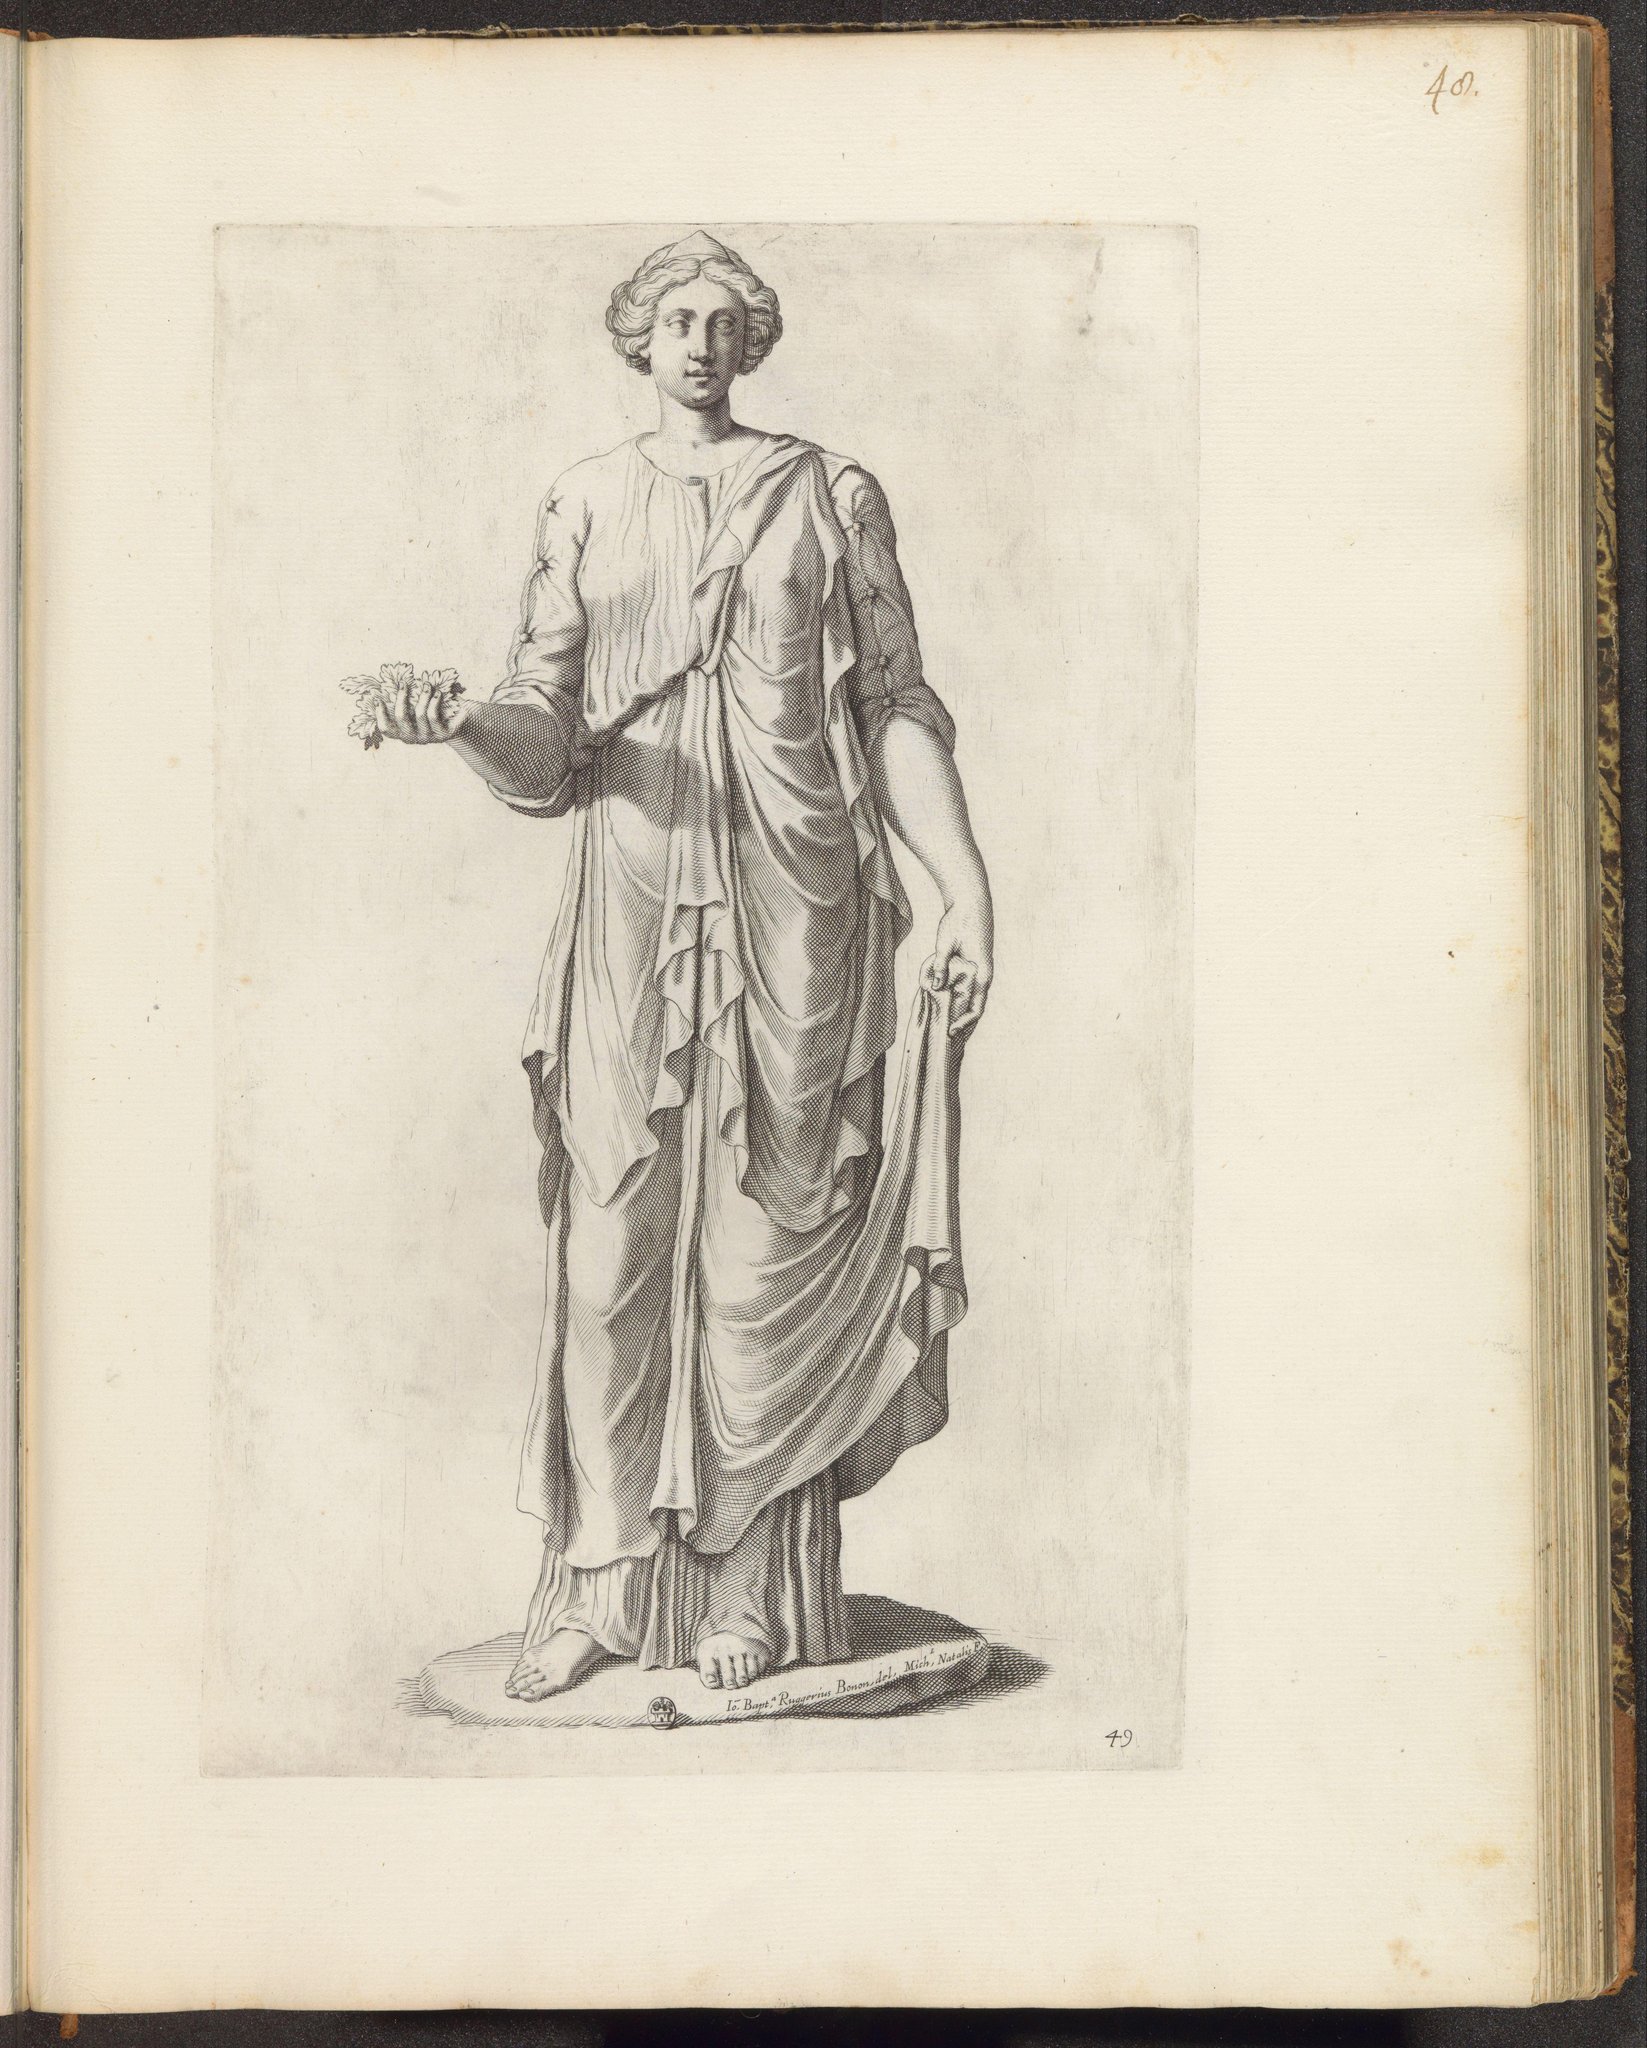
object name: print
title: Galleria Giustiniana del Marchese Vincenzo Giustiniani I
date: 1636-1647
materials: paper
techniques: engraving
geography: rome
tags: piece of sculpture, reproduction of a piece of sculpture, (story of) flora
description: Standbeeld van Flora, gekleed in klassiek gewaad, een diadeem in het haar. In haar linkerhand draagt zij bladeren, met haar rechterhand houdt zij haar kleed vast. Op de basis het wapenschild van Vincenzo Giustiniani. Prent maakt deel uit van een album met een serie prenten naar de sculpturen in de verzameling in de Galleria Giustiniani te Rome.